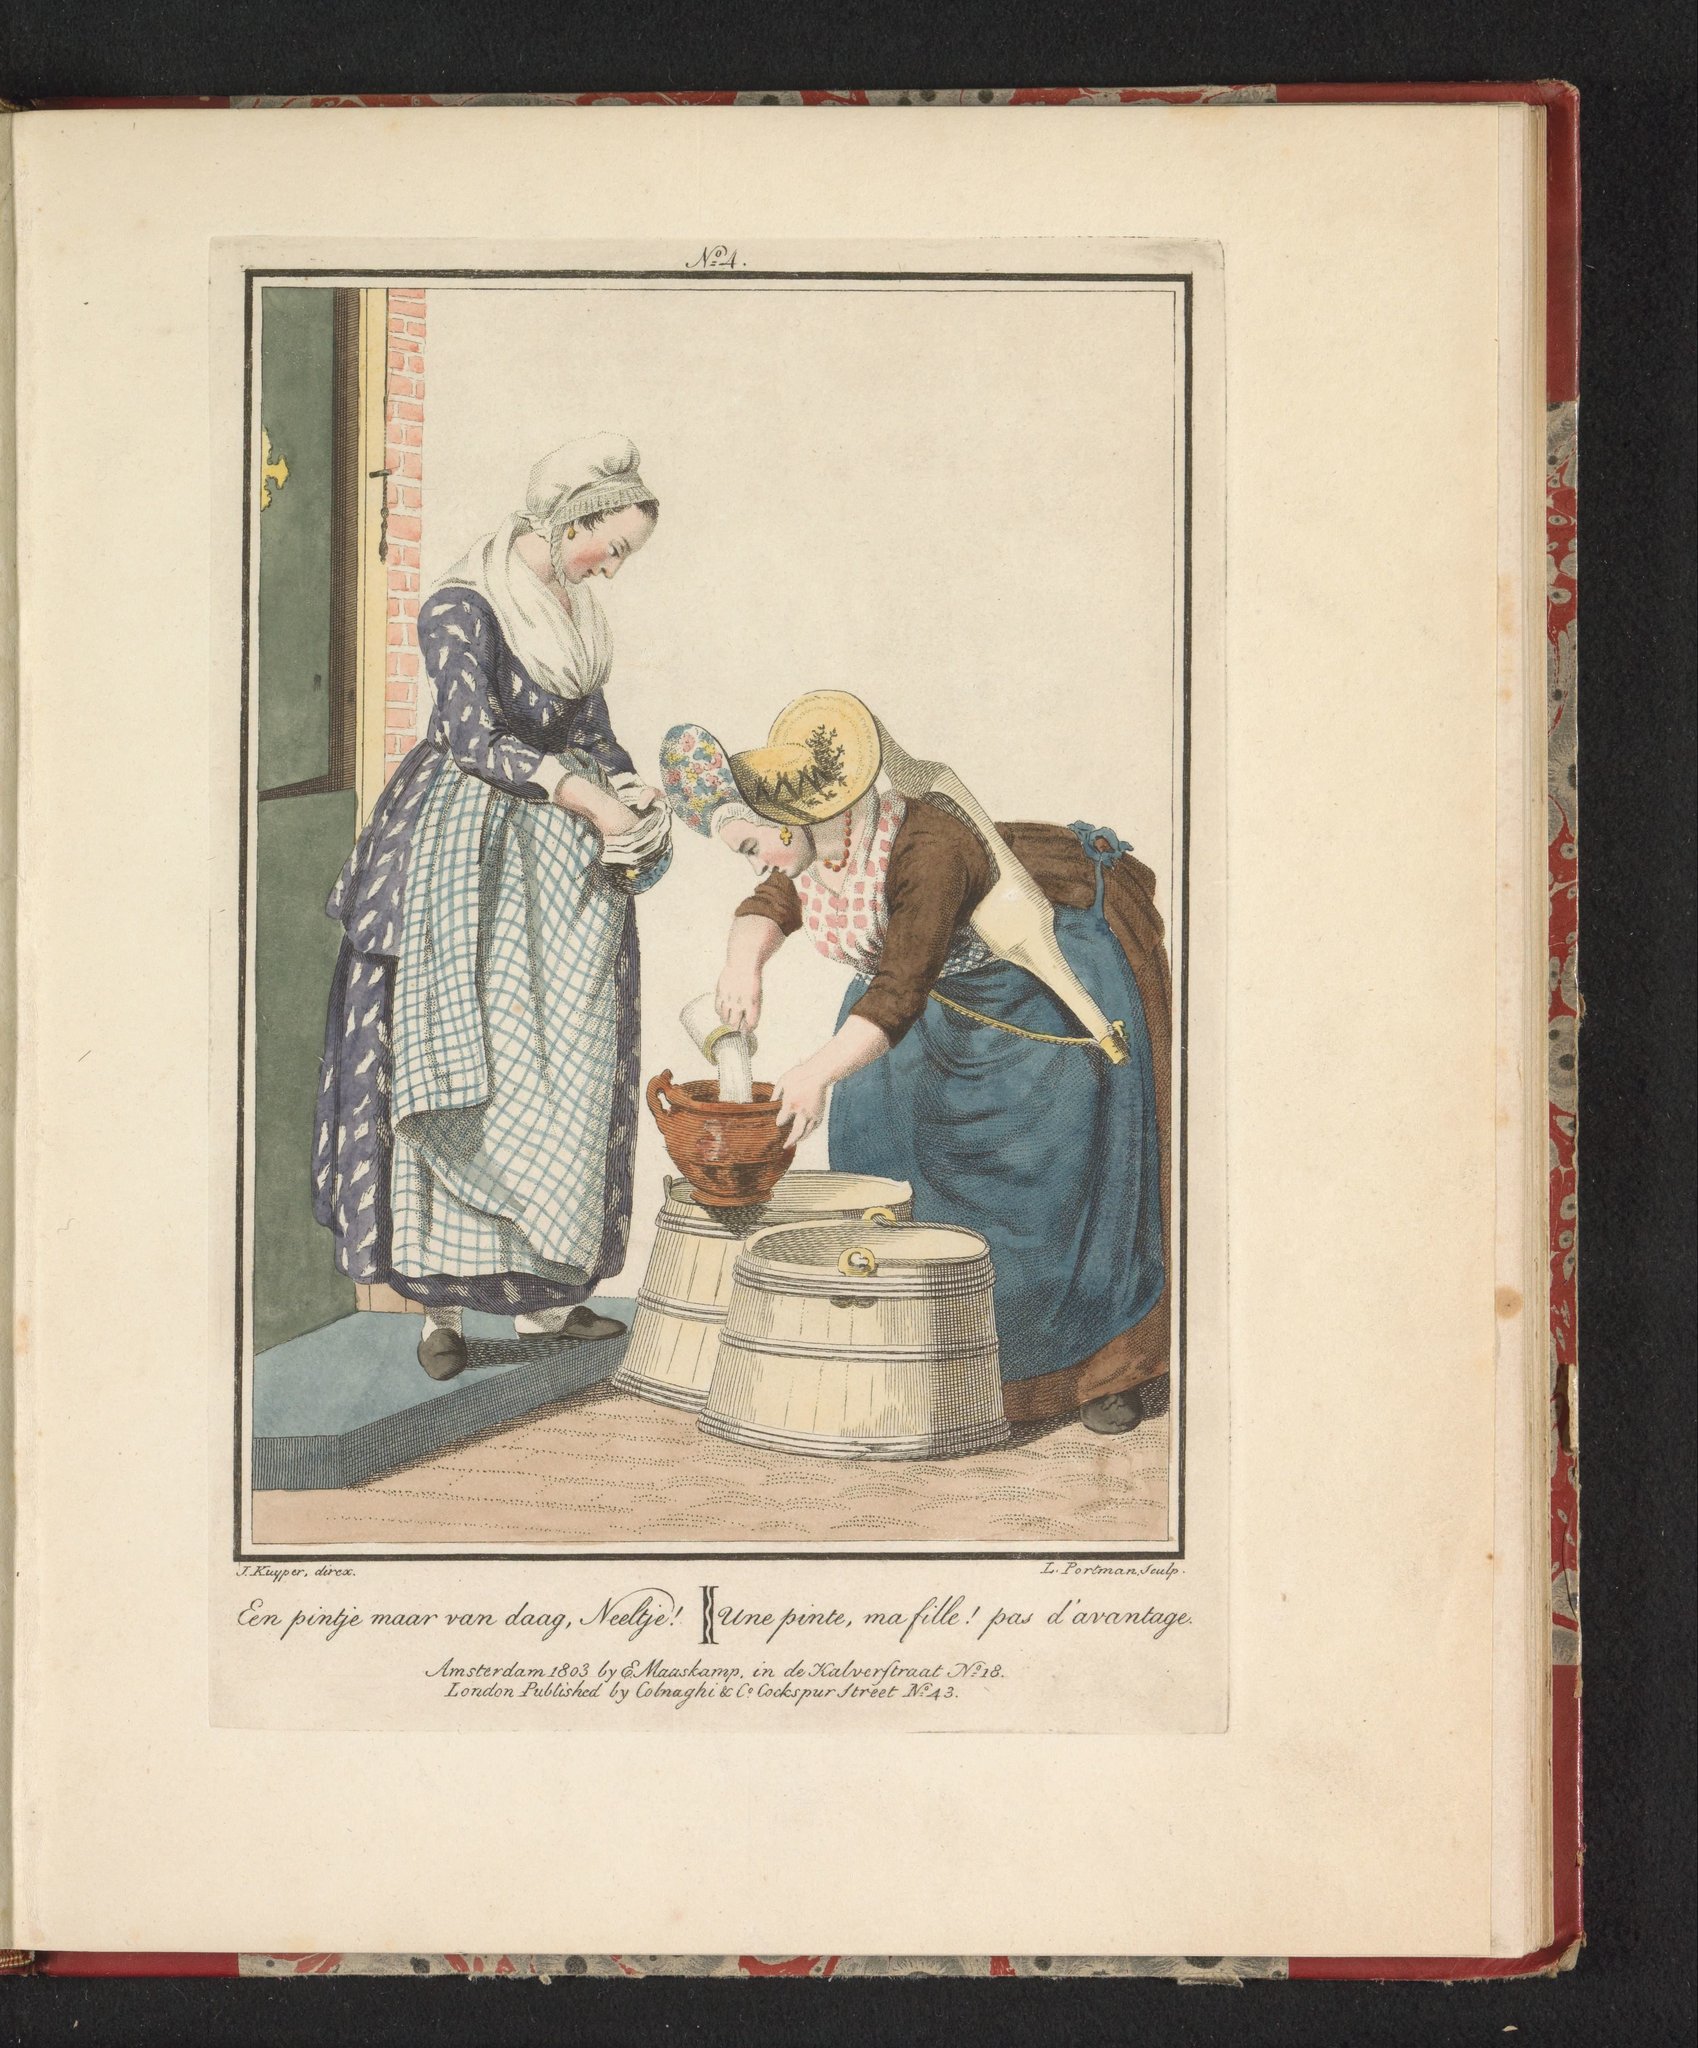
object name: book illustration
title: Een pintje maar van daag, Neeltje! / Une pinte, ma fille! pas d'avantage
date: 1803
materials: paper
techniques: etching, hand coloring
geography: amsterdam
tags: street-trader - bb - women engaged in trade and commerce, clothes, costume (+ women's clothes), milkmaid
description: Een dienstmeid koopt melk van een melkverkoopster aan de deur. Zij giet een pint melk in een kom. Eerste aflevering van vier platen, verschenen in 1803. Onderdeel van een gebonden uitgave van de reeks van twintig platen van Nederlandse klederdrachten in de Bataafse Republiek aan het begin van de negentiende eeuw door Maaskamp, ca. 1807.